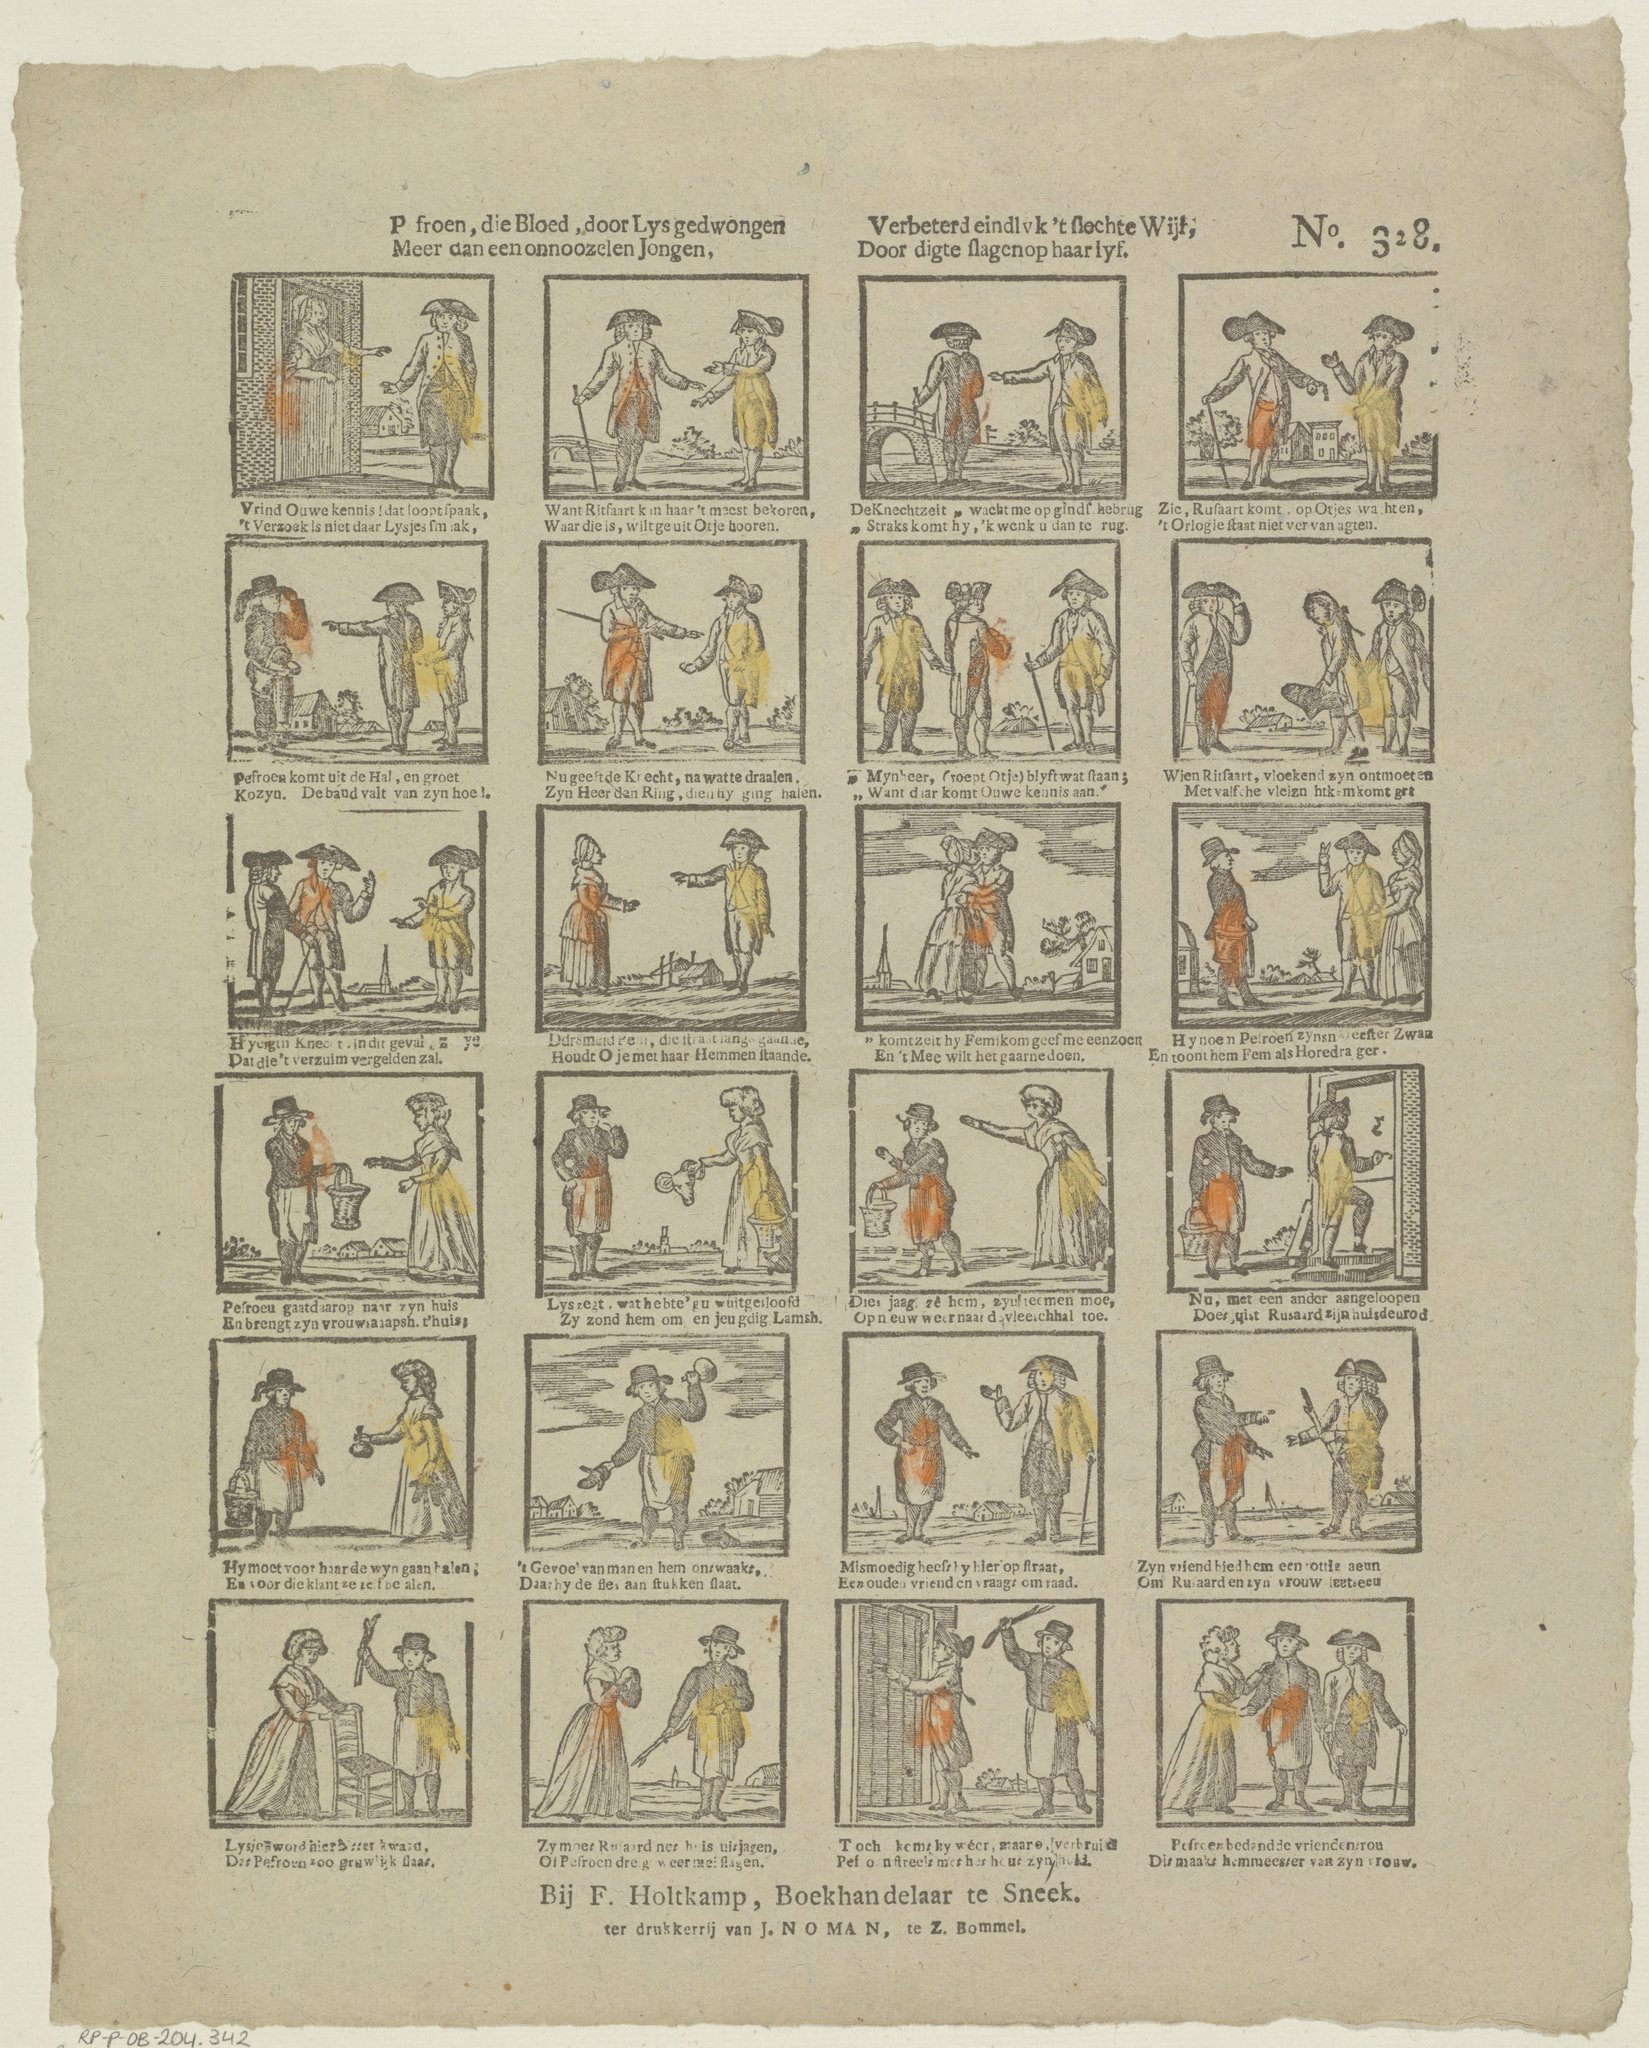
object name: popular print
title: Pefroen, die bloed, doos lys gedwongen / Meer dan een onnoozelen jongen / Verbeterd eindlyk 't slechte wyf; / Door digte slagen op haar lyf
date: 1806-1830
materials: paper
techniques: colour, letterpress printing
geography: zaltbommel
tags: adultery, satyr play, farce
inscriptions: collector's mark: Lugt 2760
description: Blad met 24 voorstellingen uit de klucht 'Pefroen met het schaapshoofd' van Ysbrand Vincent uit 1691. Onder elke afbeelding een tweeregelig vers. Genummerd rechtsboven: No. 328.